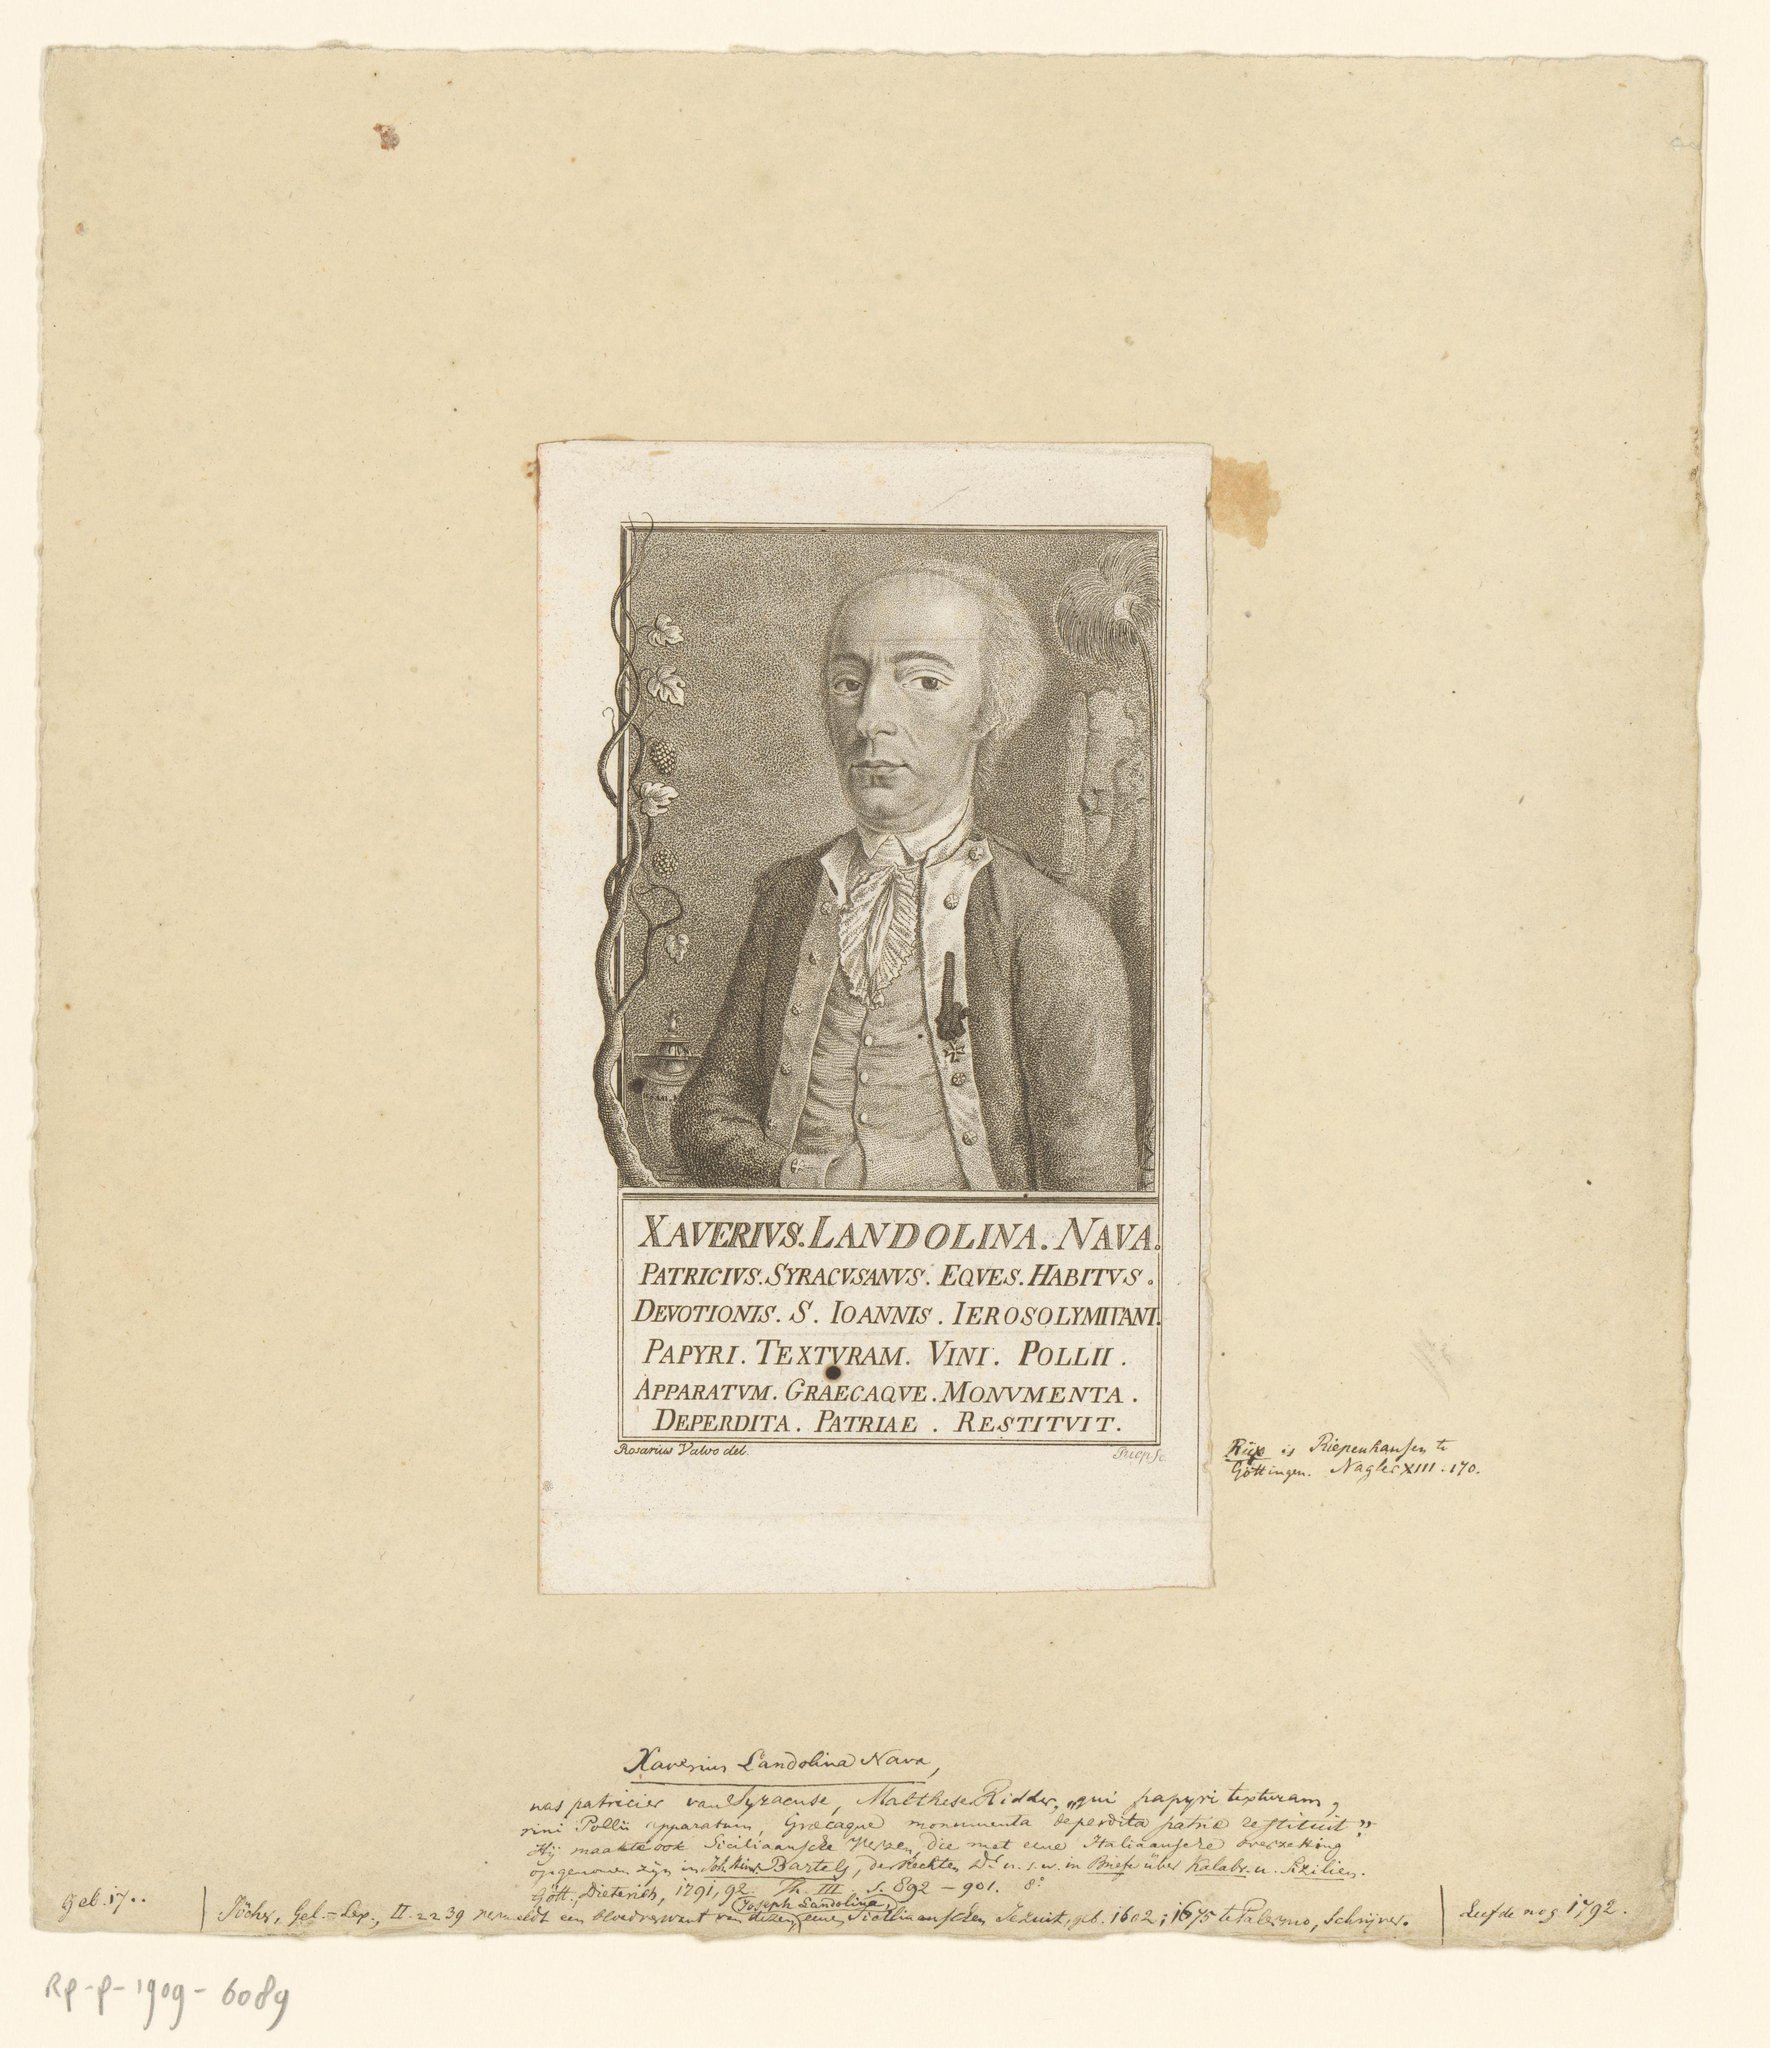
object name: print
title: Portret van Saverio Landolina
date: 1775-1840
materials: paper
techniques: engraving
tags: plants (in general), historical persons, medals and other marks of military honour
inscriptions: collector's mark: Lugt 2228